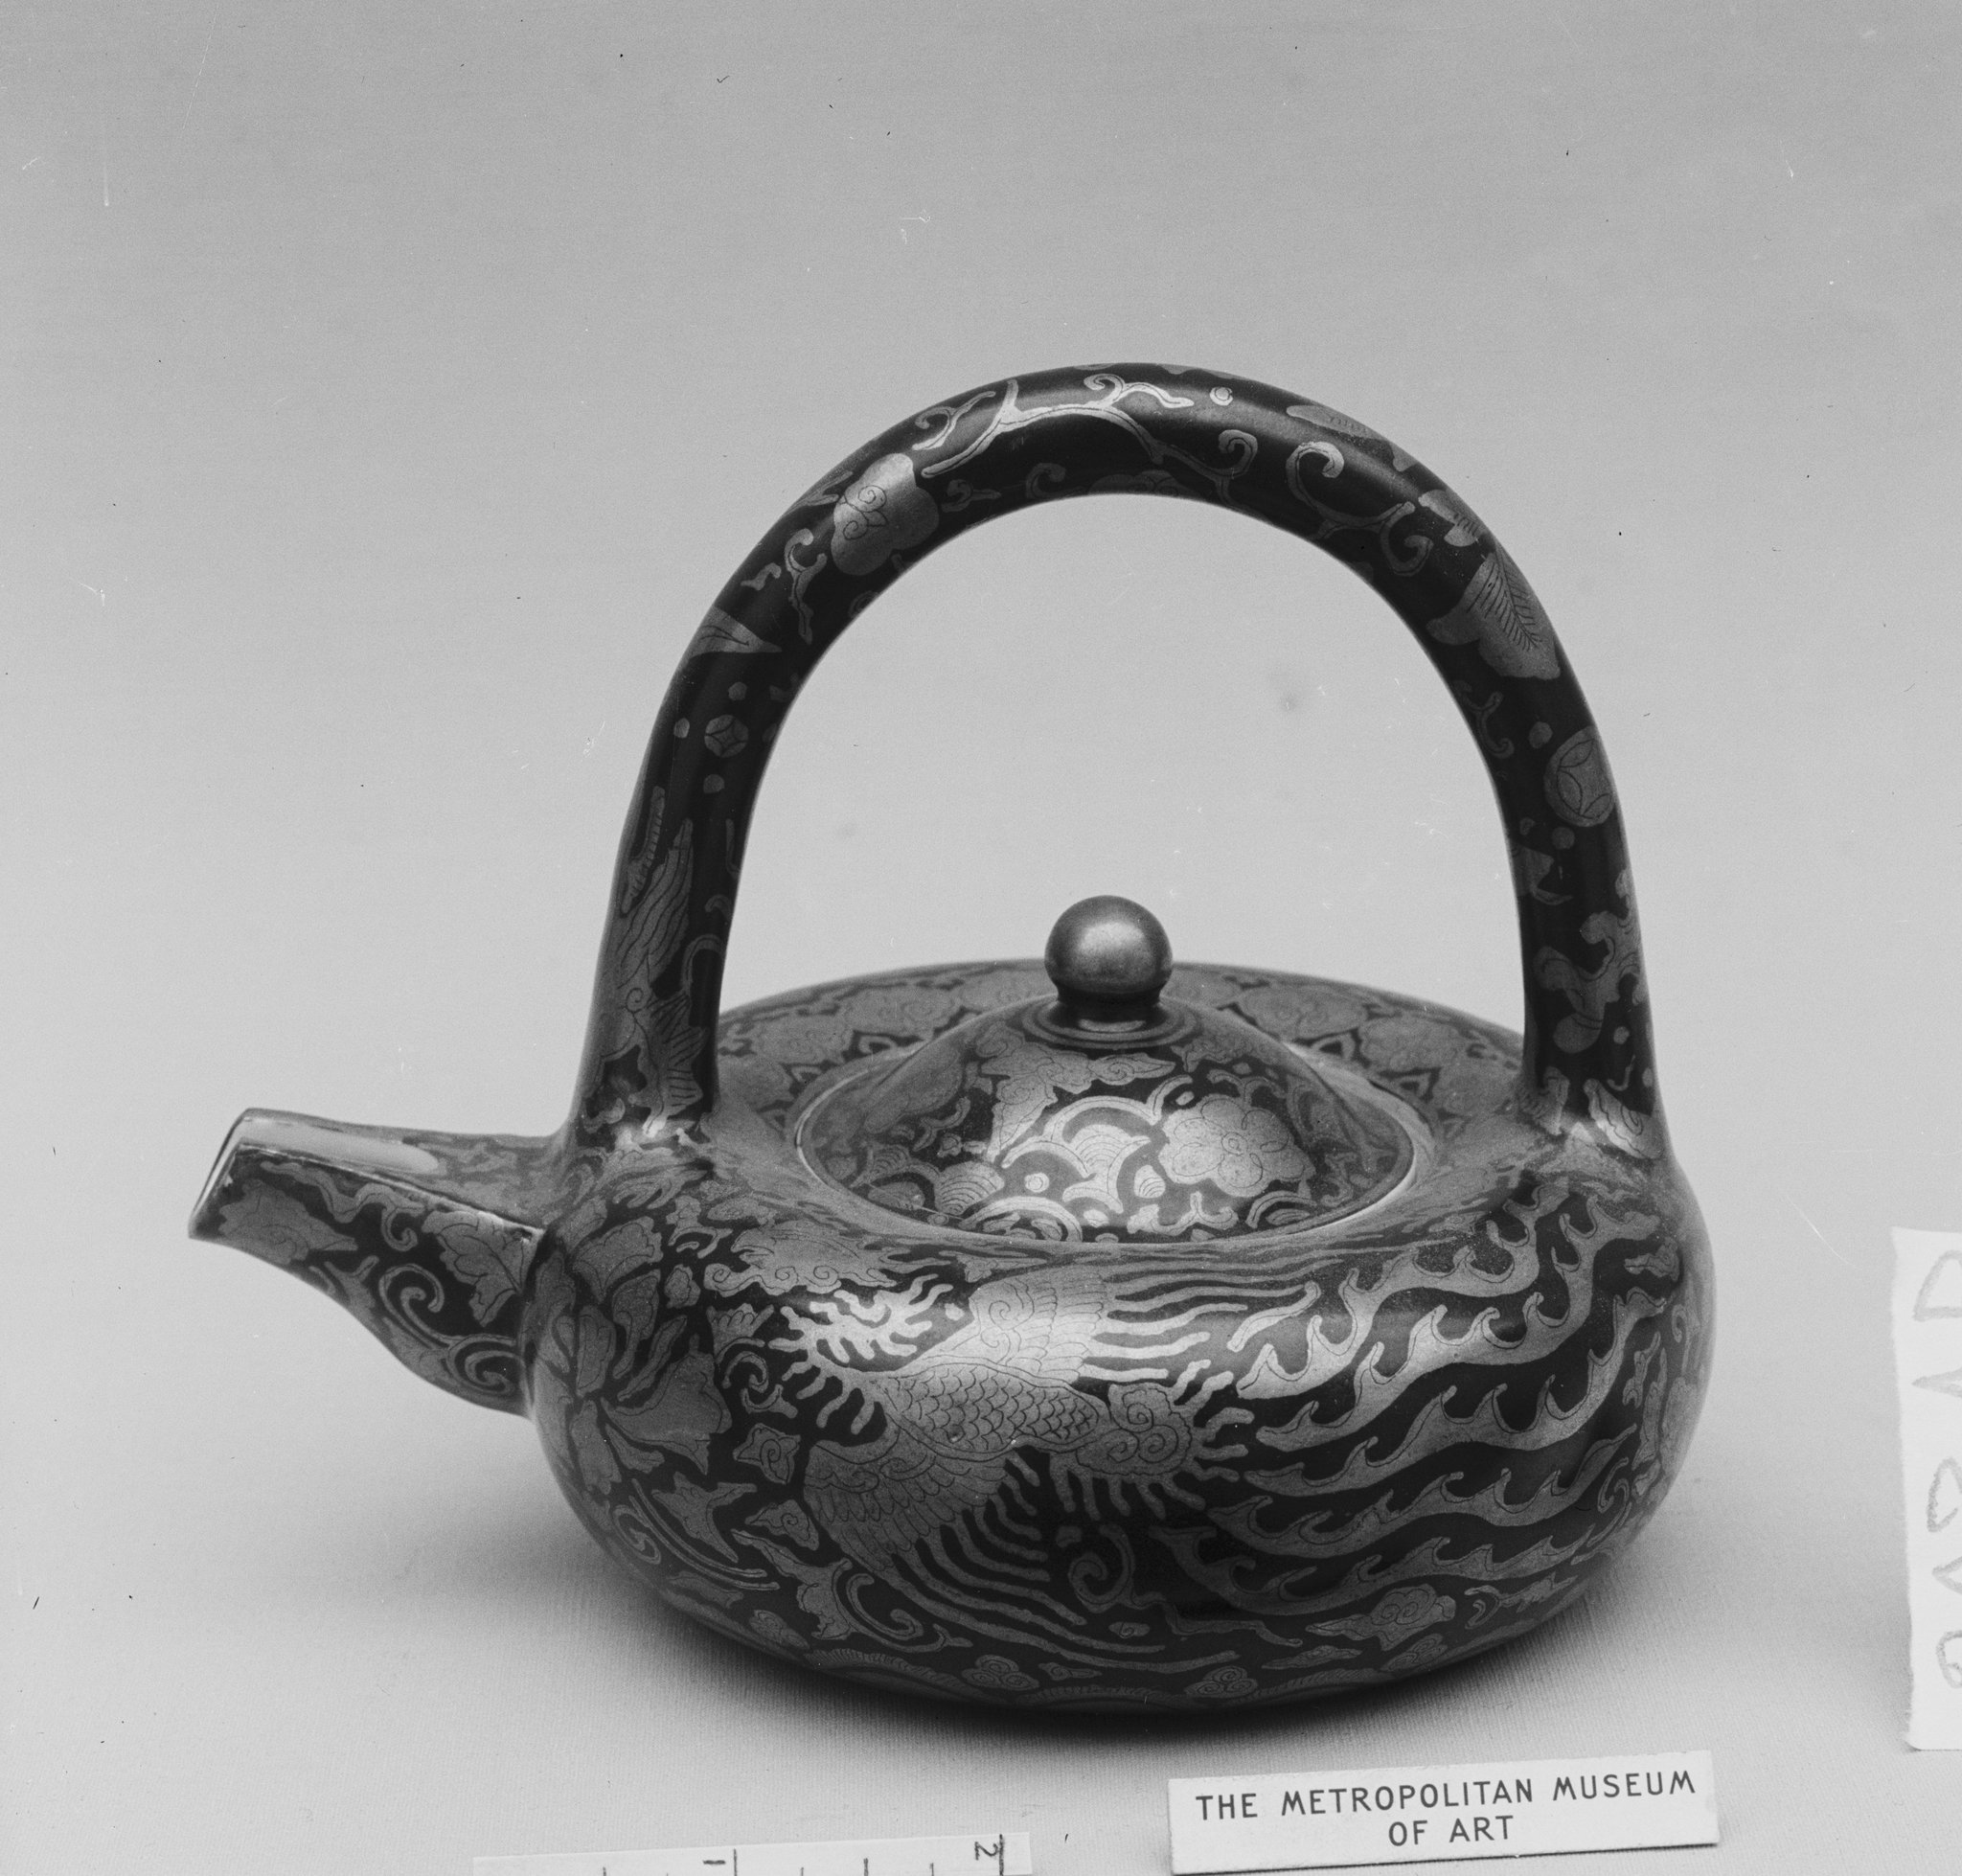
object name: sake ewer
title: Sake Ewer (Chōshi) with Phoenixes and Auspicious Patterns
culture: japanese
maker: eiraku hozen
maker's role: artist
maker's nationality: japanese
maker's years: 1795-1854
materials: glaze, gold, porcelain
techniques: painting